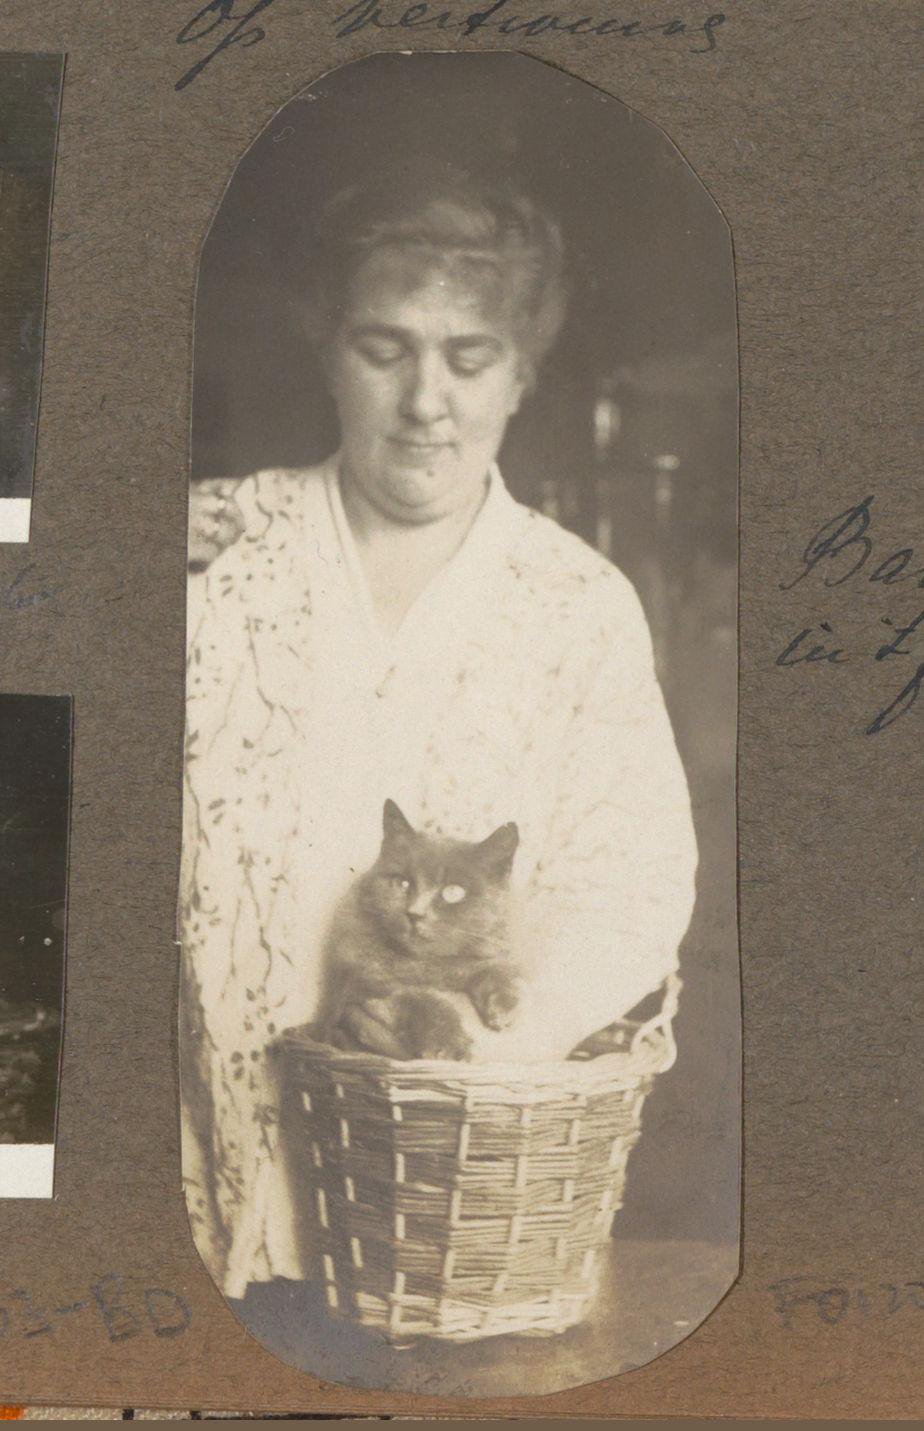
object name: photograph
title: Baby in 't fruitmandje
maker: Anonymous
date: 1920-1930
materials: photographic support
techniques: gelatin silver print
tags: adult woman, cat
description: Onderdeel van fotoalbum van een onbekende Nederlandse familie met opnames van Suriname, Europa en Nederlands-Indië.